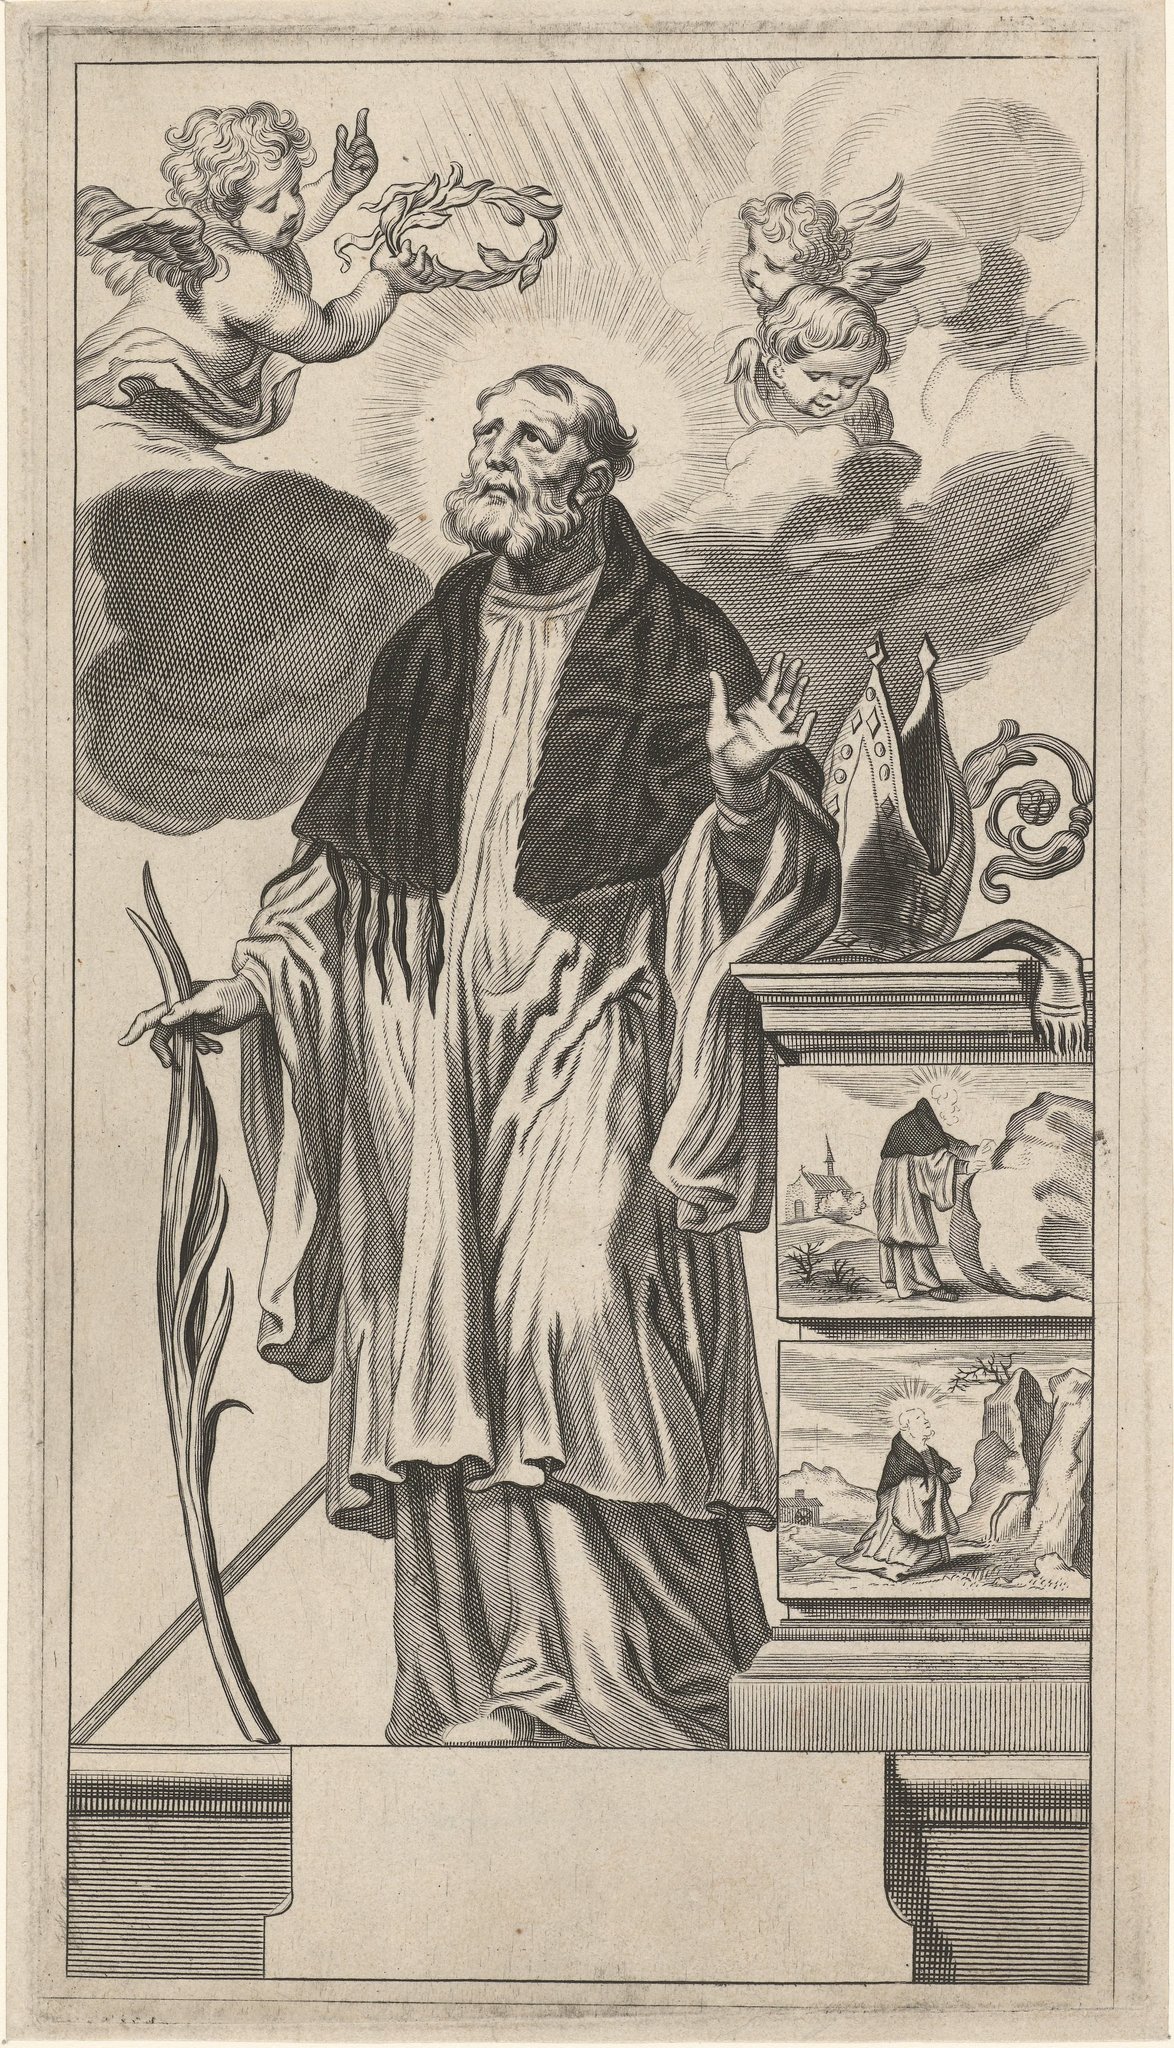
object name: print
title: Heiligen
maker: theodor matham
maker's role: draughtsman, print maker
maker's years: 1605-1676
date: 1615-1676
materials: paper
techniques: engraving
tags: cherubs, i.e. children's heads with wings, insignia of bishop, e.g. mitre, crozier, saints, crowning with laurel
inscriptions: collector's mark: Lugt 240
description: Een staande heilige, met in zijn hand een palmtak. Rechts een afbeelding van de heilige die bij een rots staat en een afbeelding waarbij die rots opensplijt en een bron ontstaat. Naast de heilige liggen bisschopsmijter- en staf. In de lucht een engel met een lauwerkrans en twee cherubijnen. Prent uit een serie van acht prenten met heiligen.